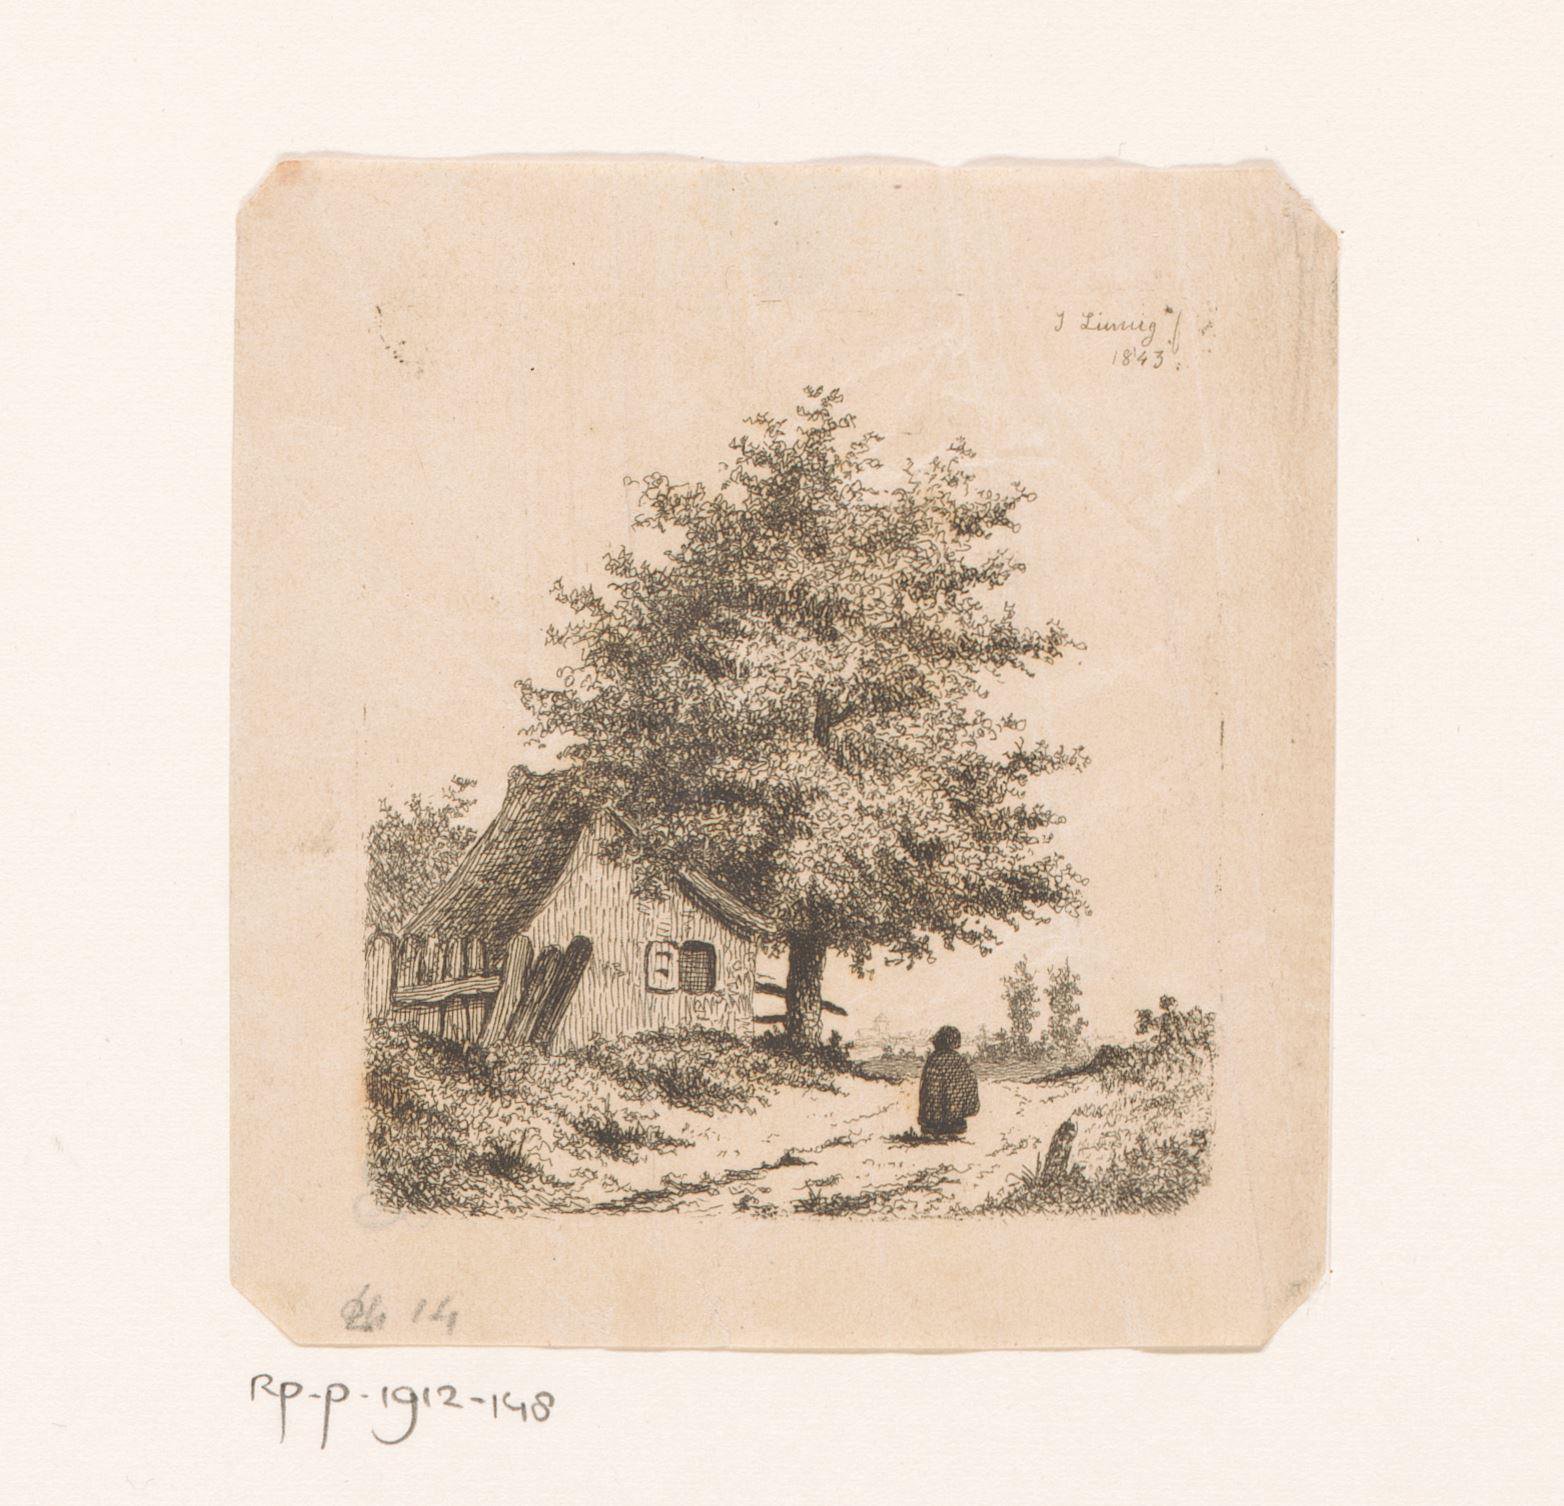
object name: print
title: Klein gebouw aan een pad in Merksem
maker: jean théodore joseph linnig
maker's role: draughtsman, print maker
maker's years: 1815-1891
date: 1843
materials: paper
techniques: etching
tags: road, path, farm or solitary house in landscape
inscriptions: collector's mark: Lugt 2228, collector's mark: Lugt 1485